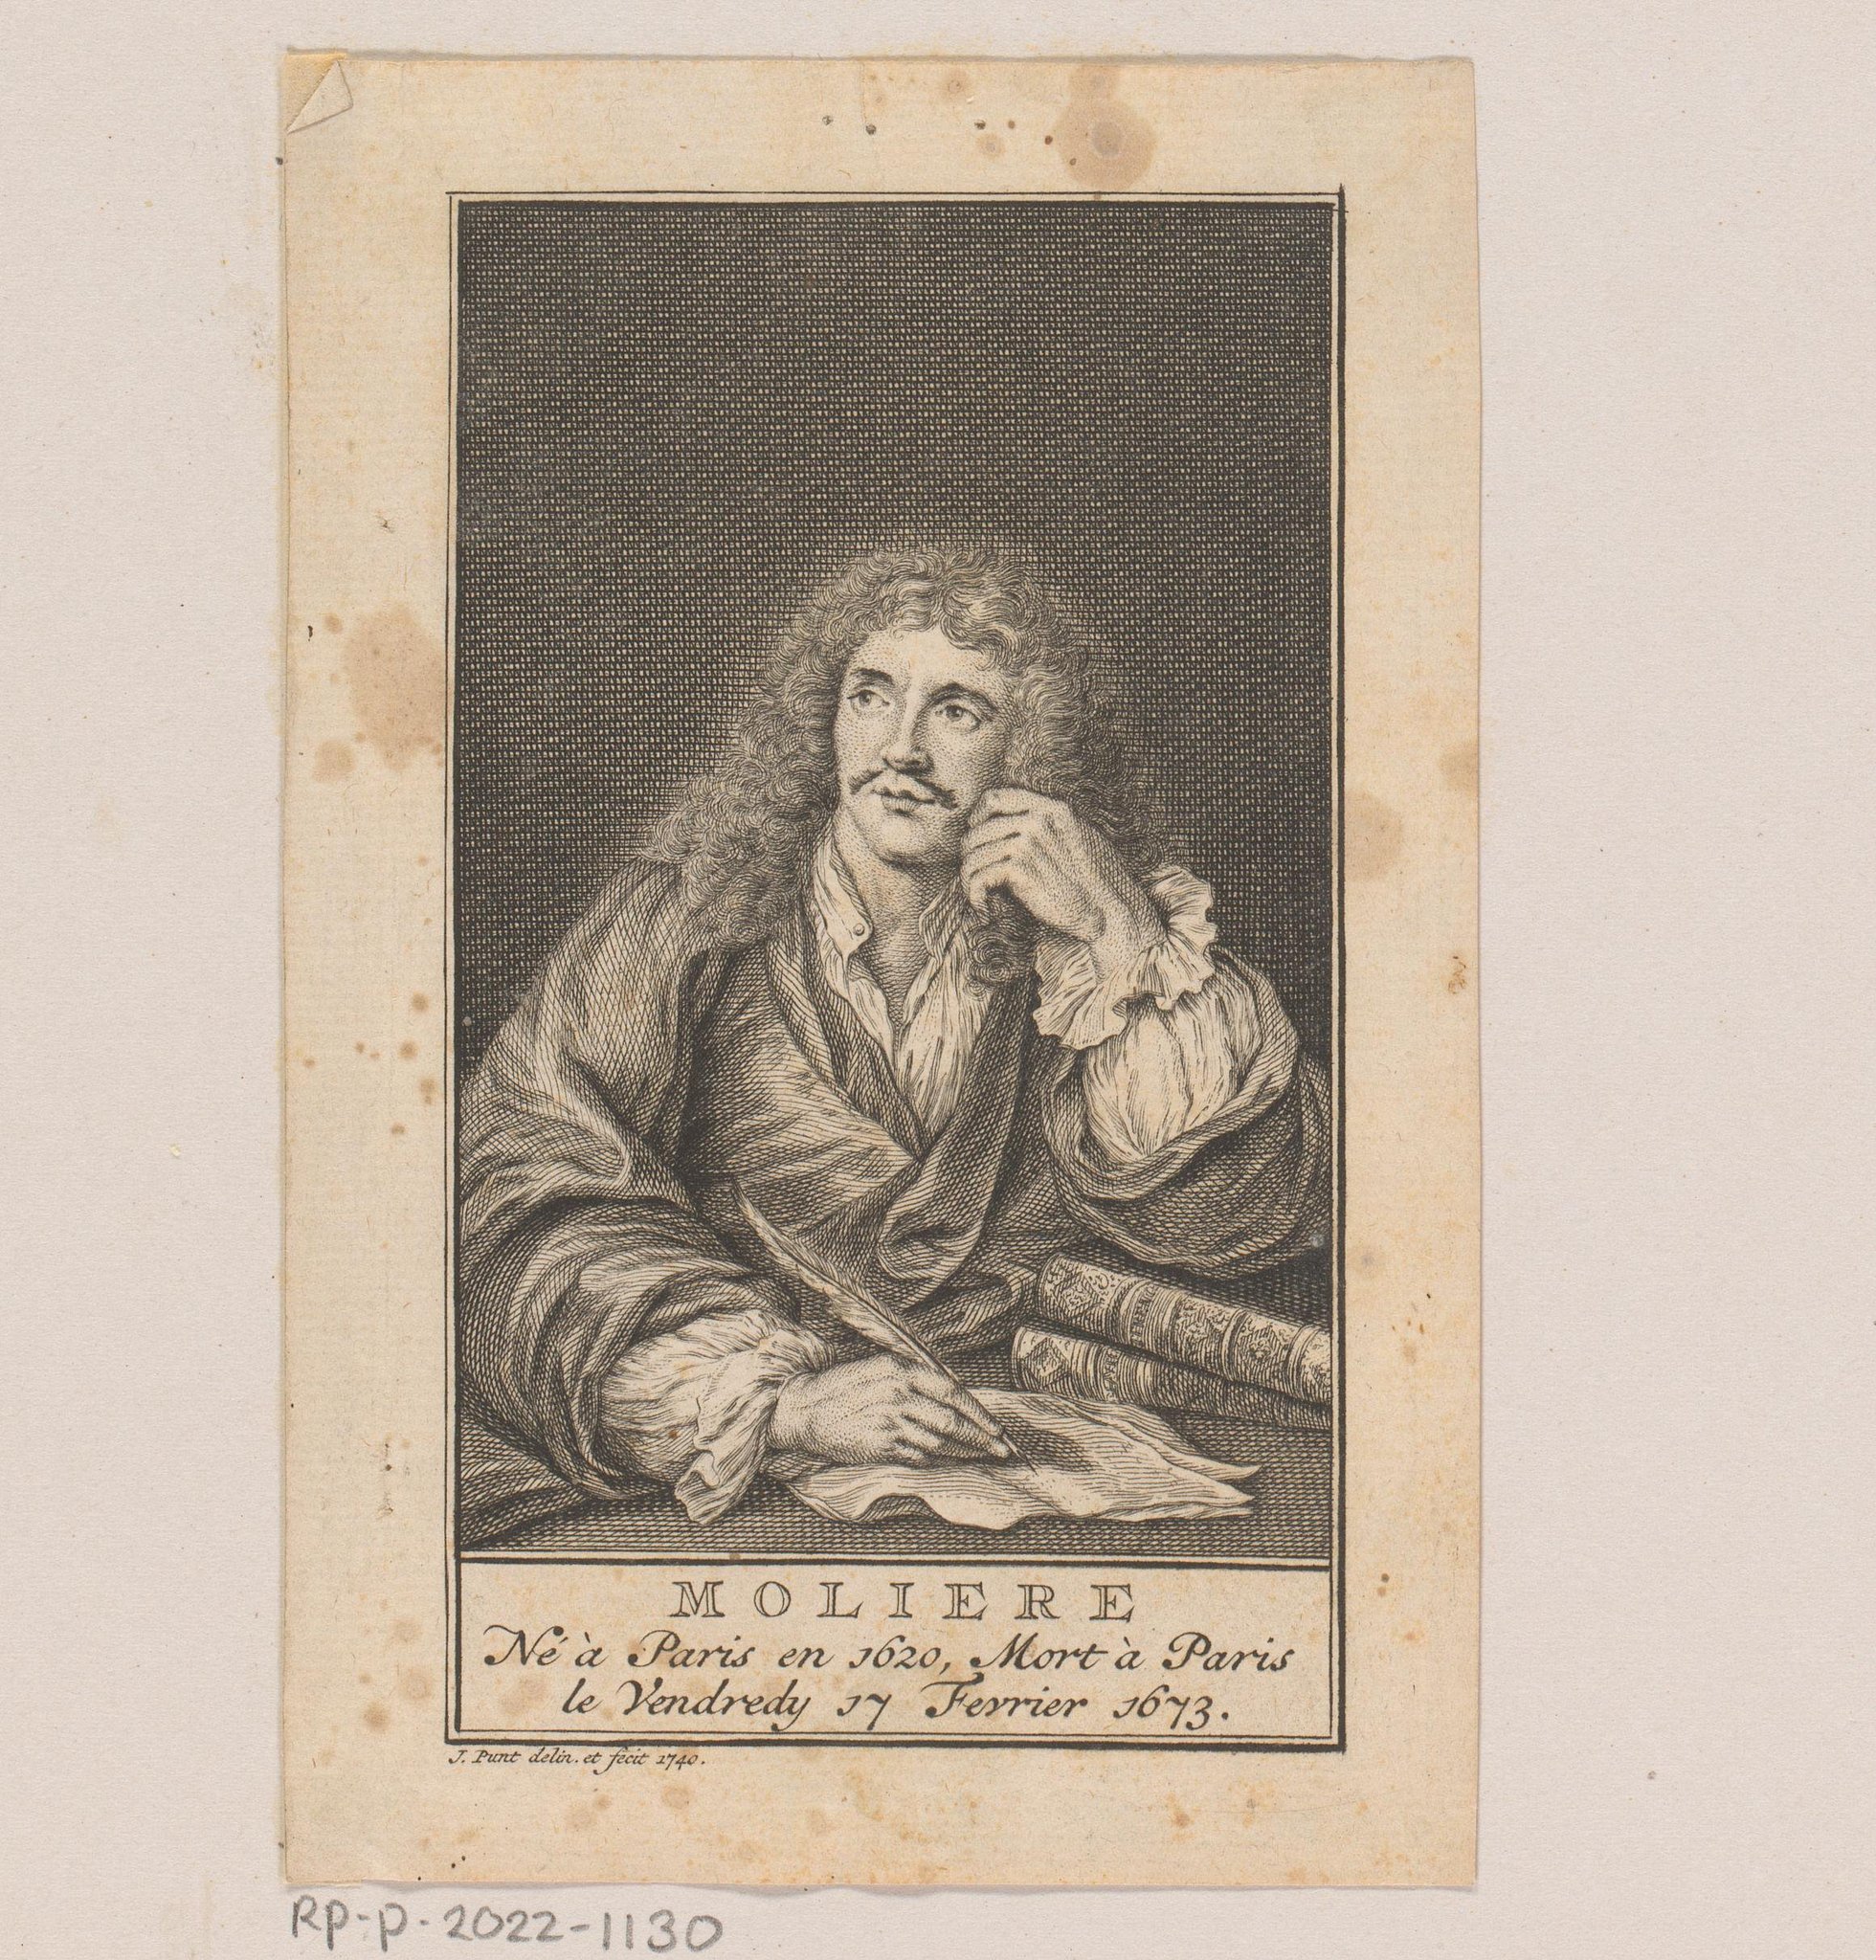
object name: print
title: Moliere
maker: jan punt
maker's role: draughtsman, print maker, publisher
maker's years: 1711-1779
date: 1740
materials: paper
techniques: engraving, etching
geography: amsterdam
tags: paris, jean baptiste poquelin molière, historical persons, writer, poet, author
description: Met tweeregelig onderschrift in het Frans.